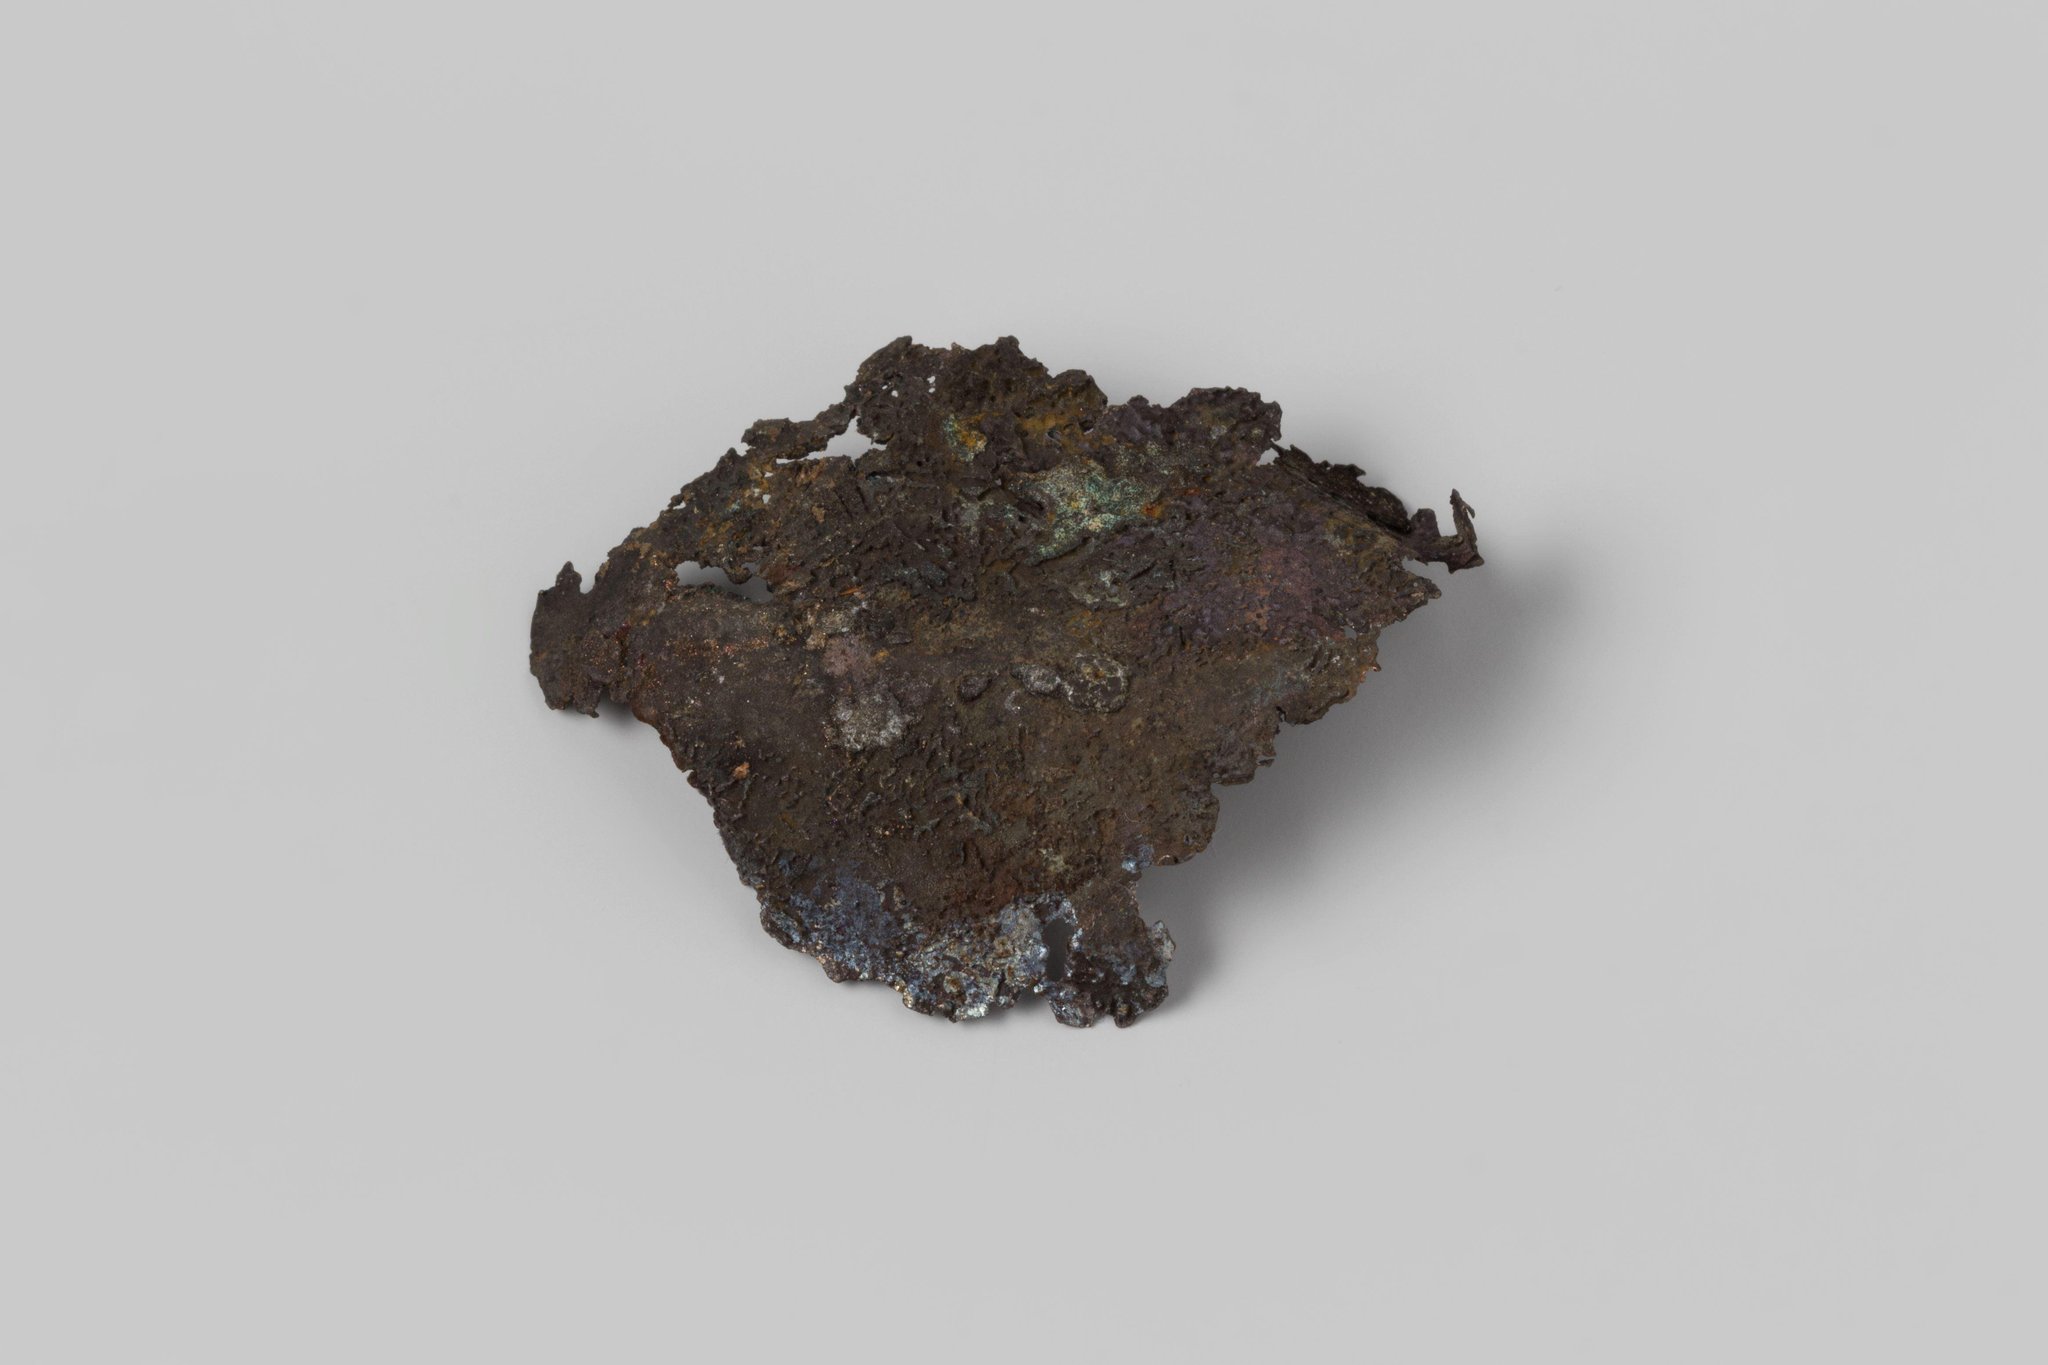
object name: scheepswrakvondst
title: Fragment van koper uit het wrak van de Oost-Indiëvaarder Hollandia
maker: Anonymous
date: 1700-1743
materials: copper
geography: netherlands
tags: verenigde oostindische compagnie, hollandia (schip), annet